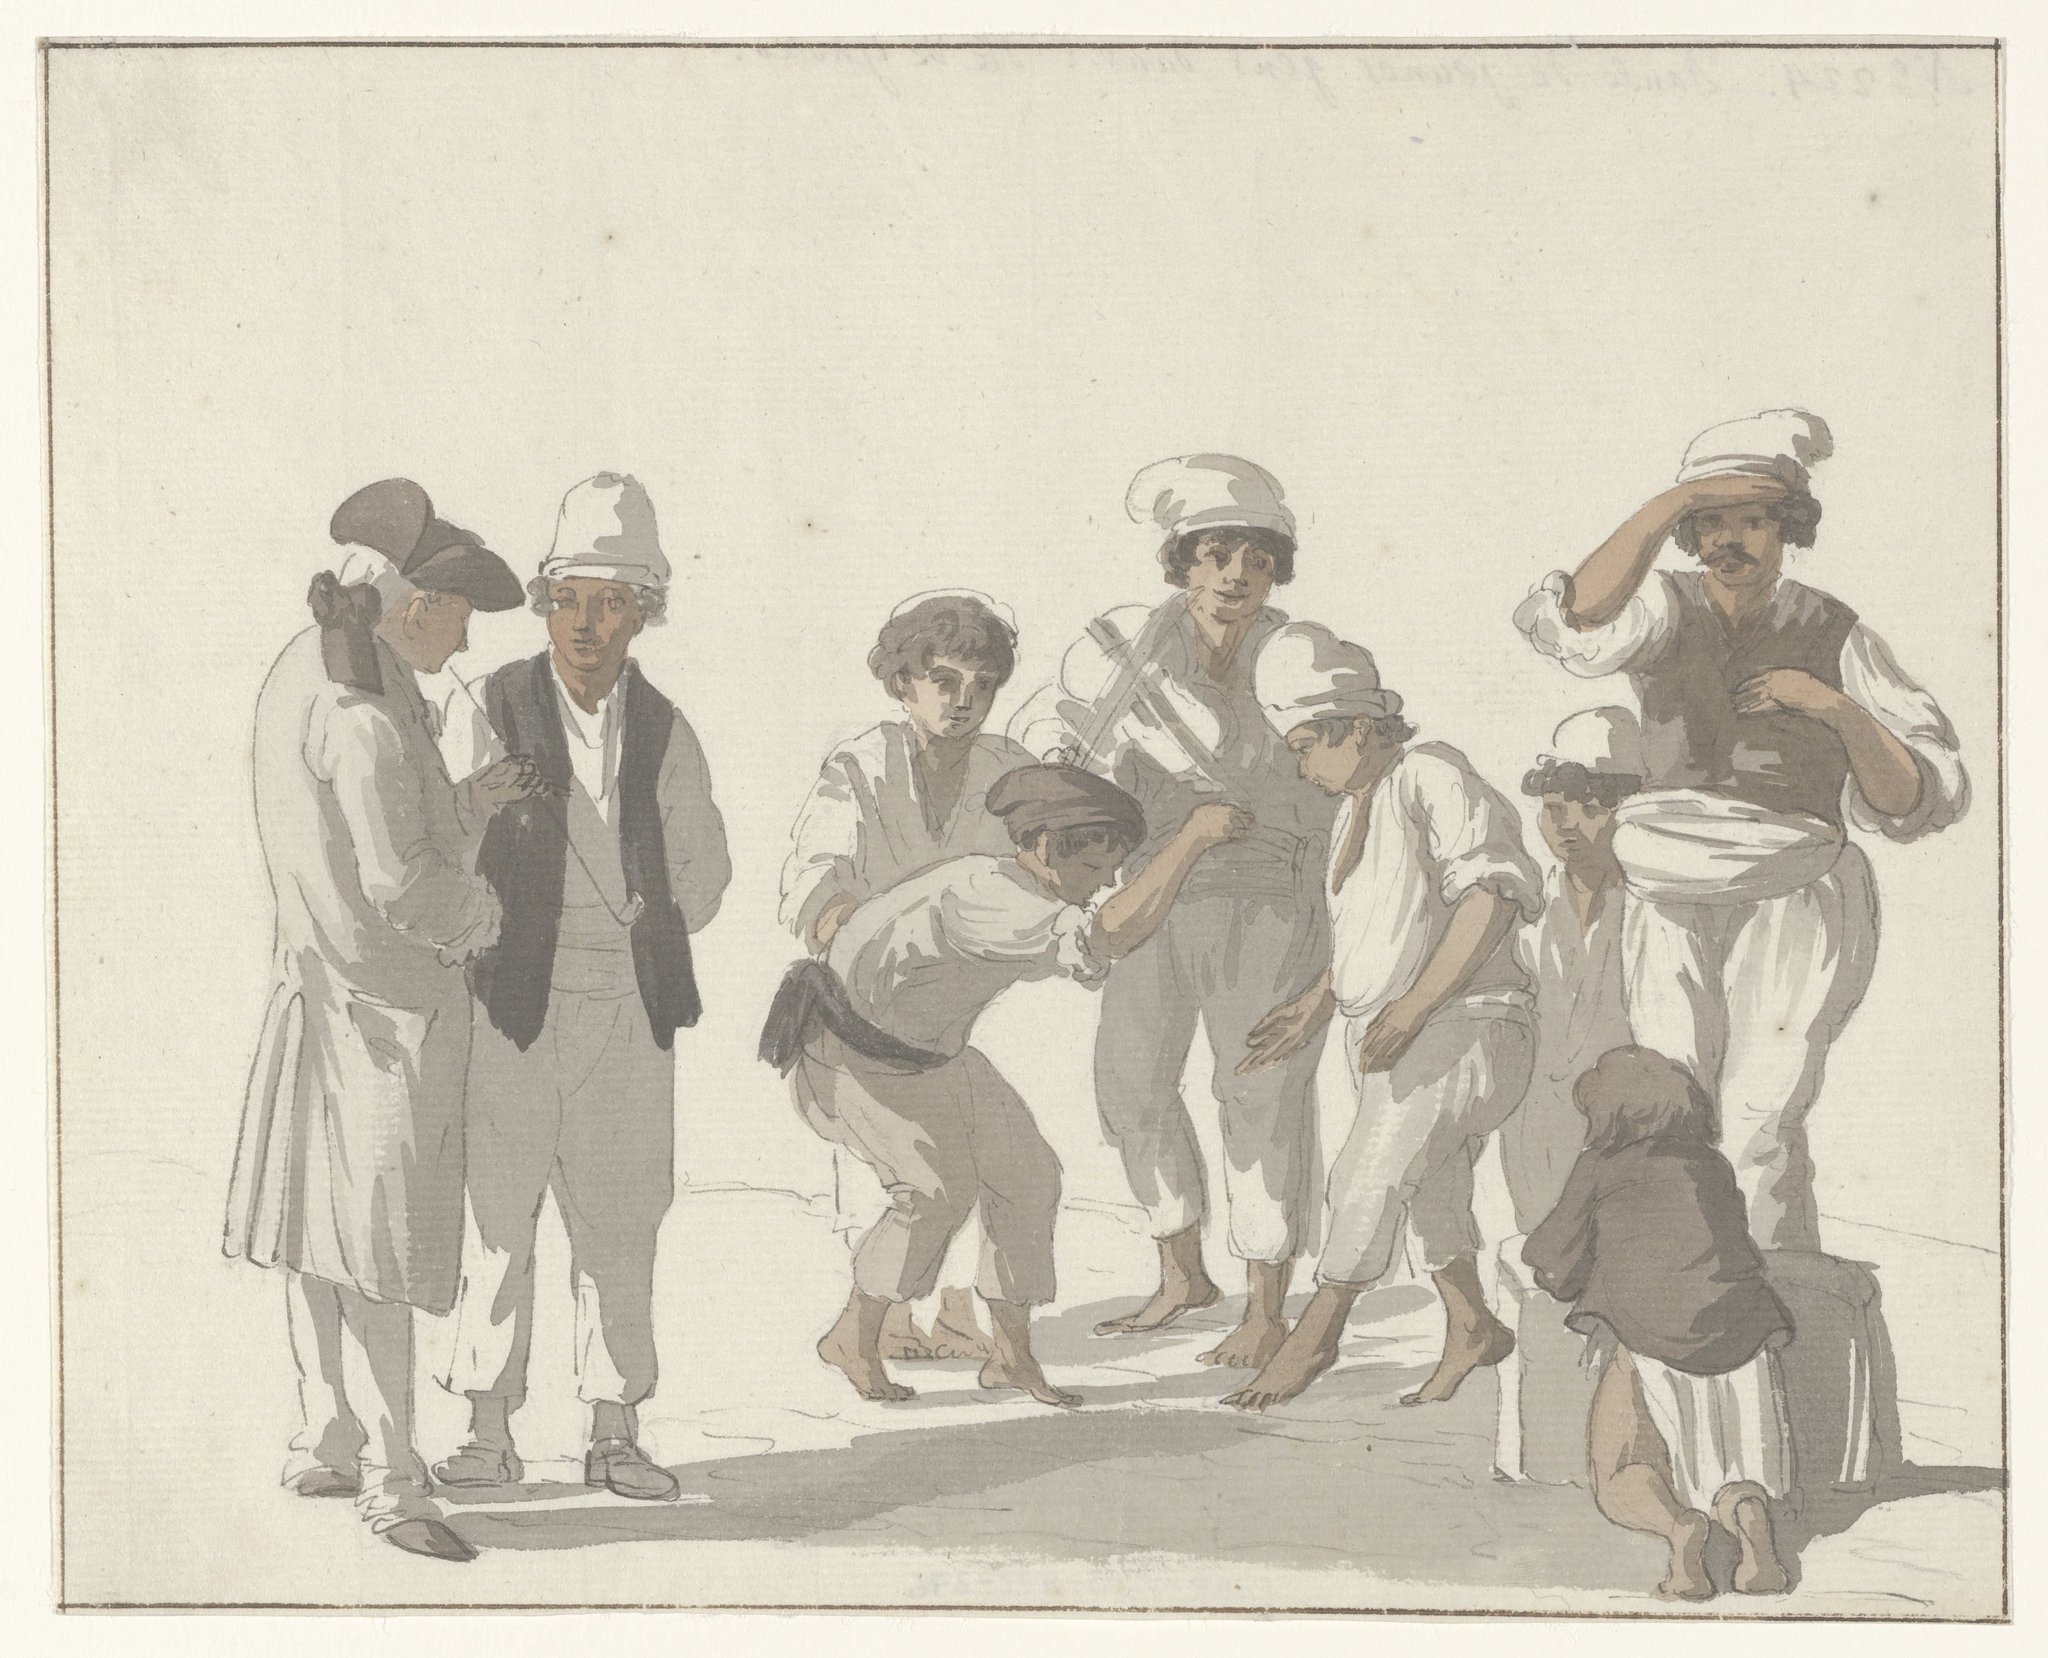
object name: drawing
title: Danse de jeunes gens dans l'île de Ghozo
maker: louis ducros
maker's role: draughtsman, print maker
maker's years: 1748-1810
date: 1778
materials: chalk, paper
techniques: brush, pen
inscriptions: inscription: ‘No 224 Danse de jeunes gens dans l'île de Ghozo’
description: Tekening uit het album 'Voyage en Italie, en Sicile et à Malte', 1778.